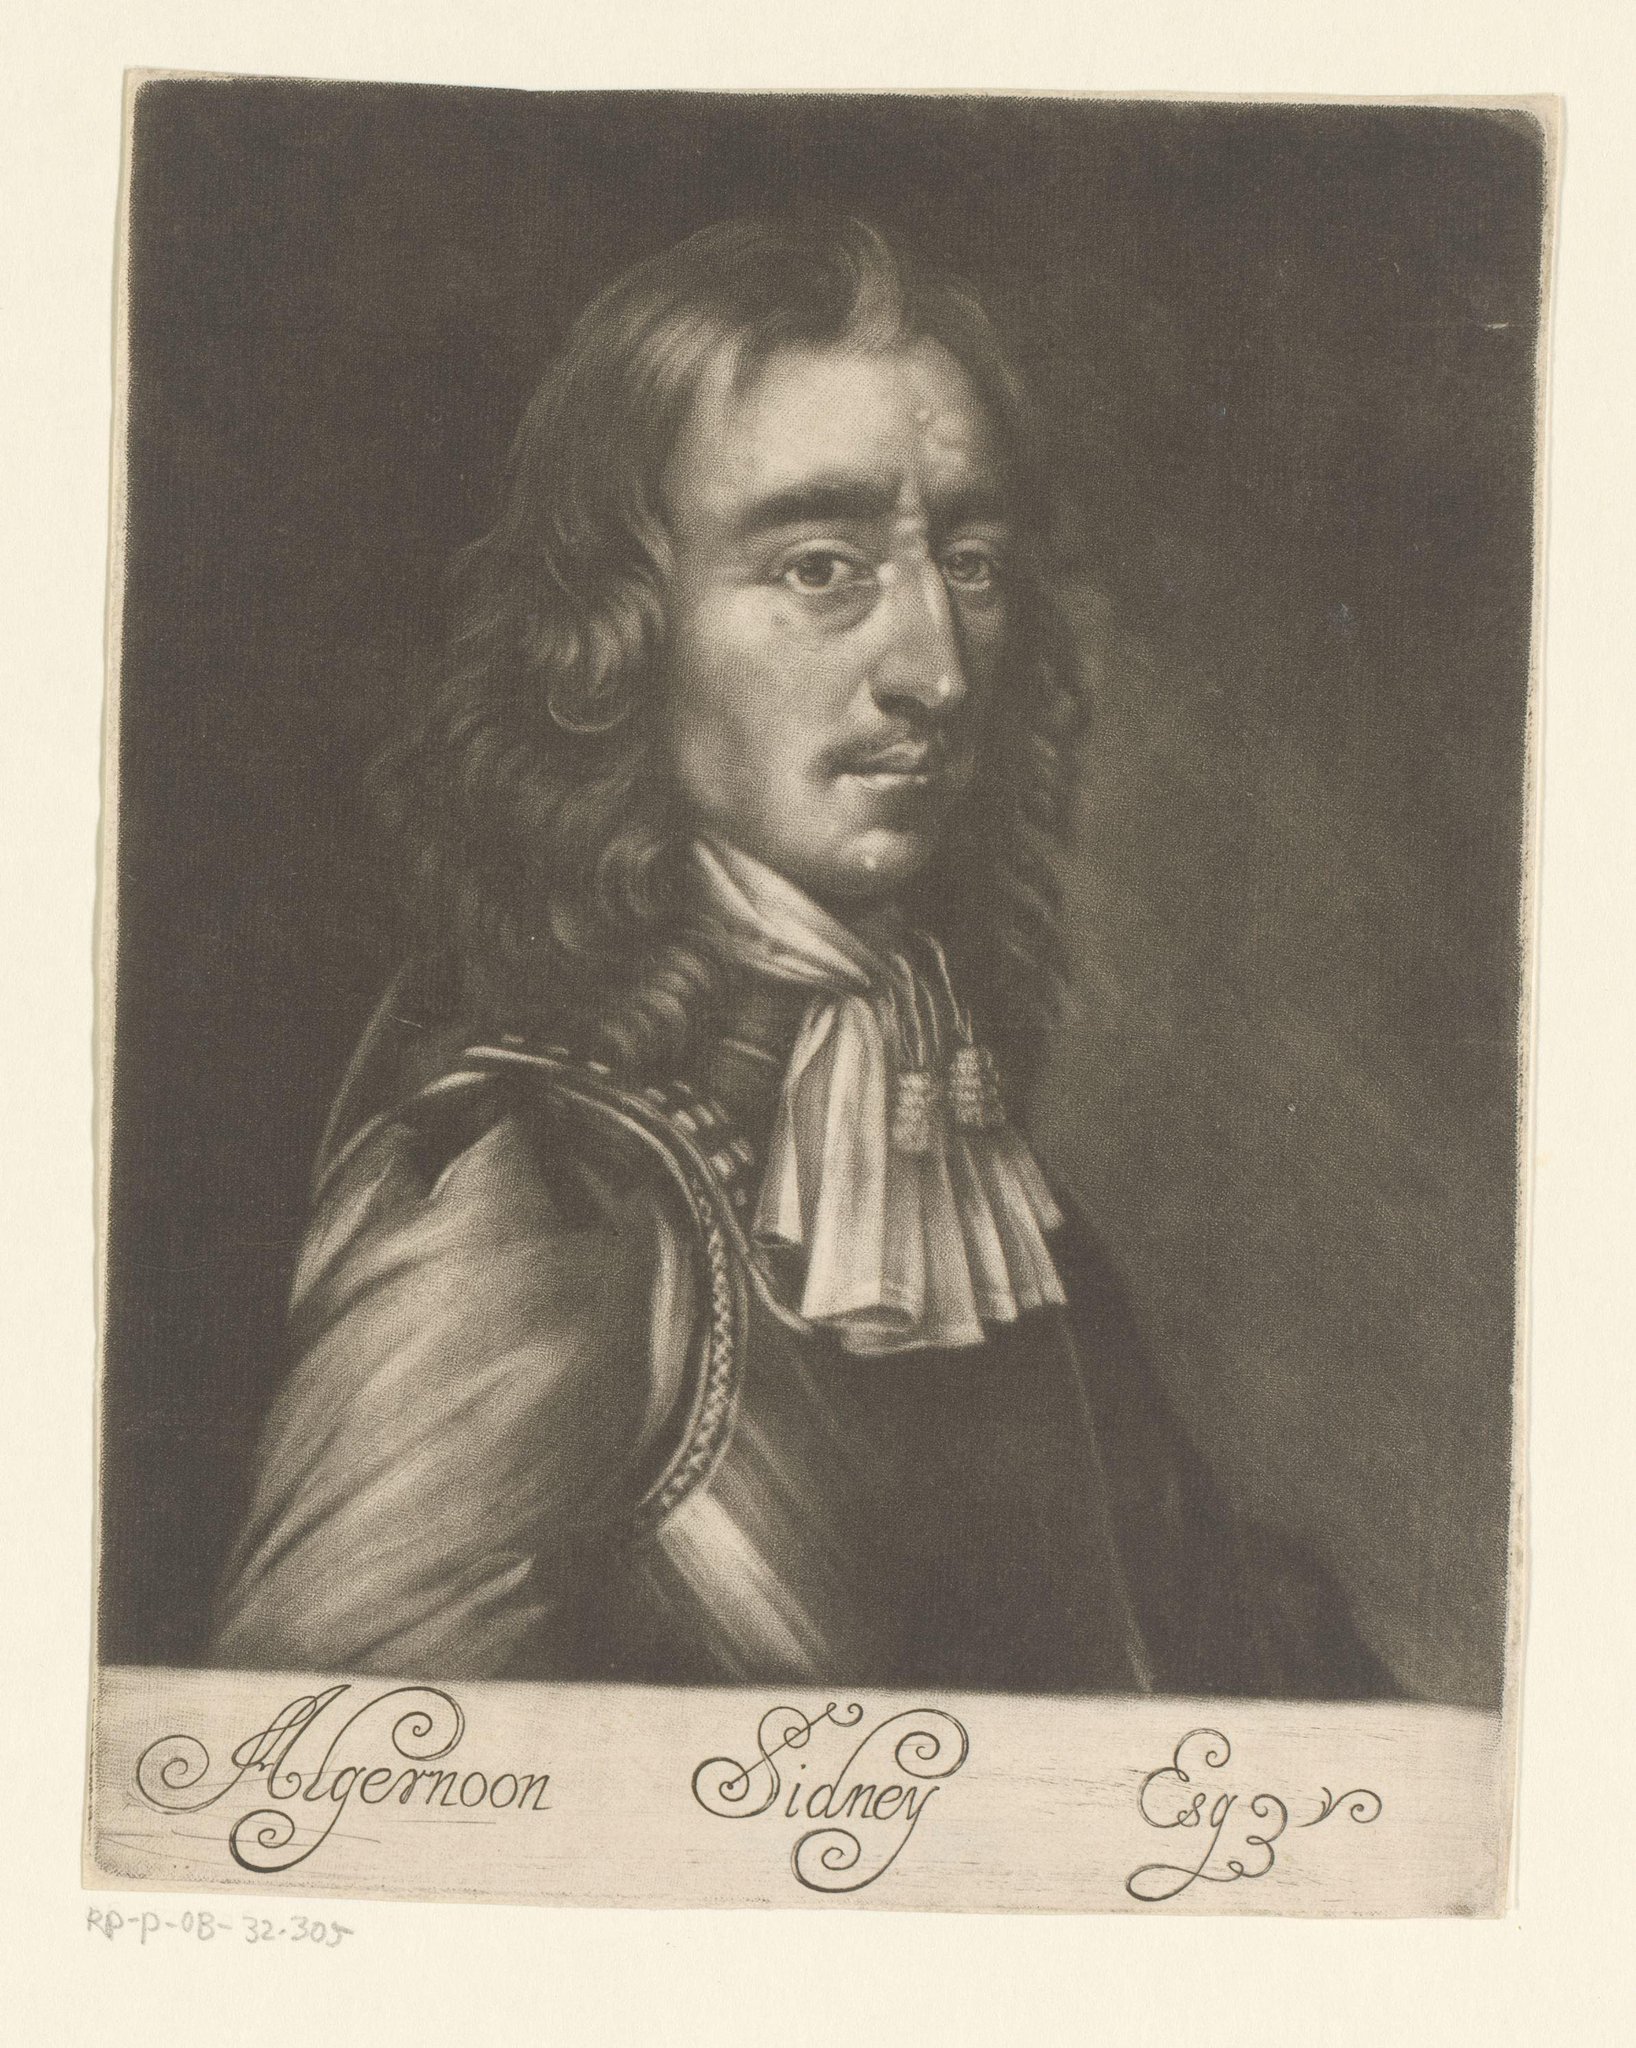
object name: print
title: Portret van Algernon Sidney Esqr.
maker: edward lutterell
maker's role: print maker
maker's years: 1650-1723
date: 1660-1723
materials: paper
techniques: etching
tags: london, politician, historical persons, diplomacy, diplomat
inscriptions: collector's mark: Lugt 2228